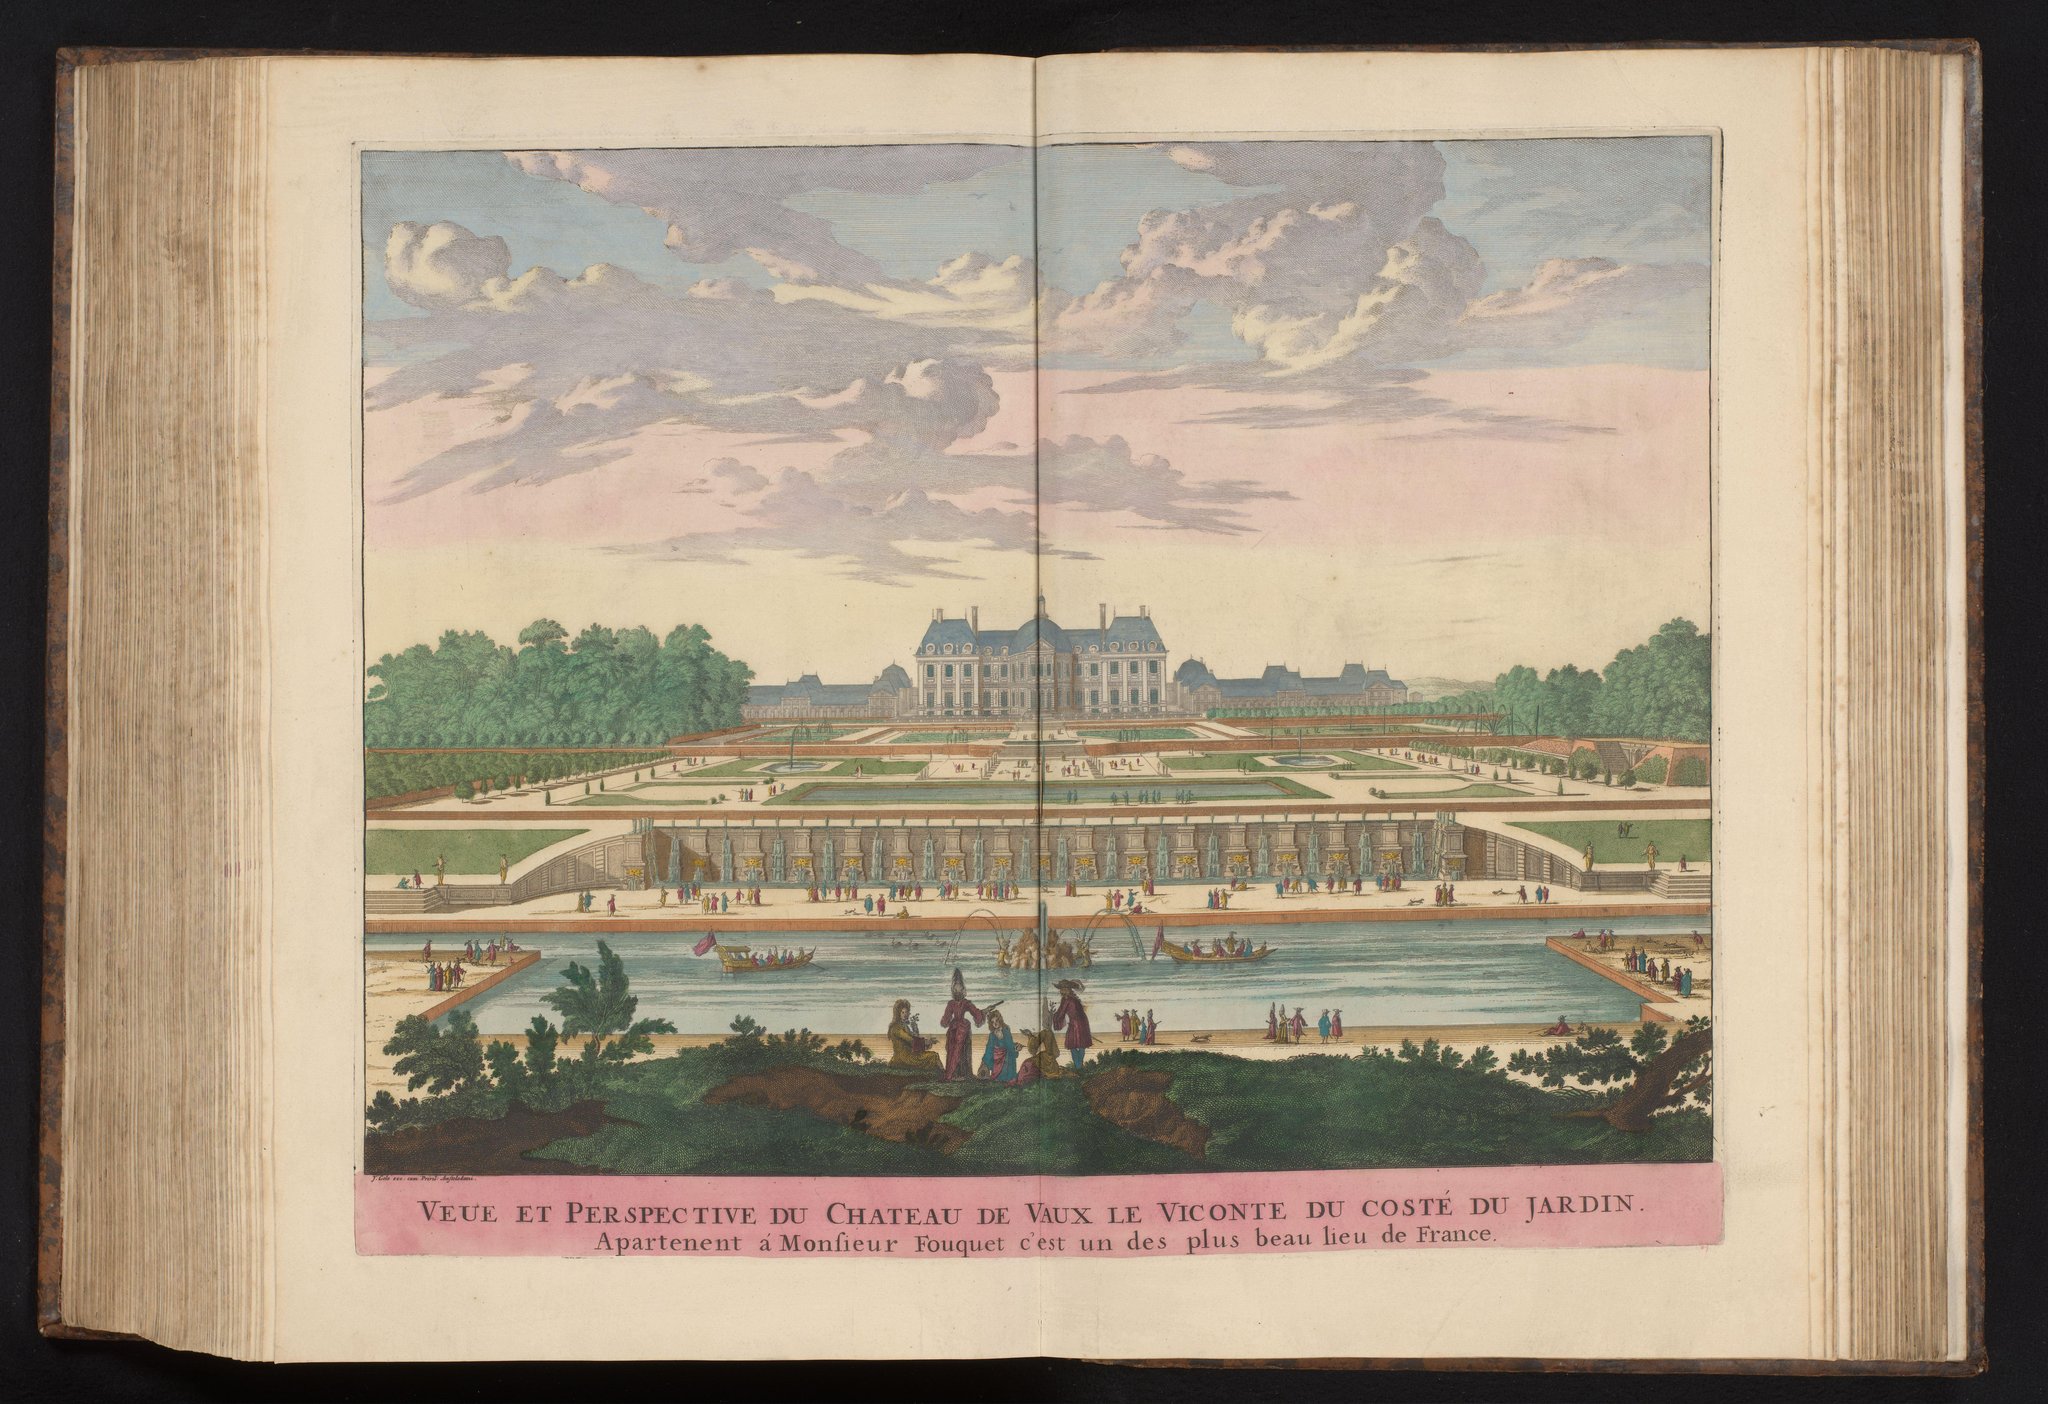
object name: album leaf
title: Veue et Perspective du Chateau de Vaux Le Viconte du Costé du Jardin Appartenant á Monsieur Fouquet c'est un des plus beau lieu de France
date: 1681-1724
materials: paper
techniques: etching, hand coloring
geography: northern netherlands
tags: castle, french or architectonic garden; formal garden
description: Gezicht op Château de Vaux-le-Vicomte vanaf de tuinen. Op de voorgrond een elegant gezelschap. Daarachter het kanaal Ru d'Ancoeuil met enkele schepen. Prent maakt deel uit van een album.